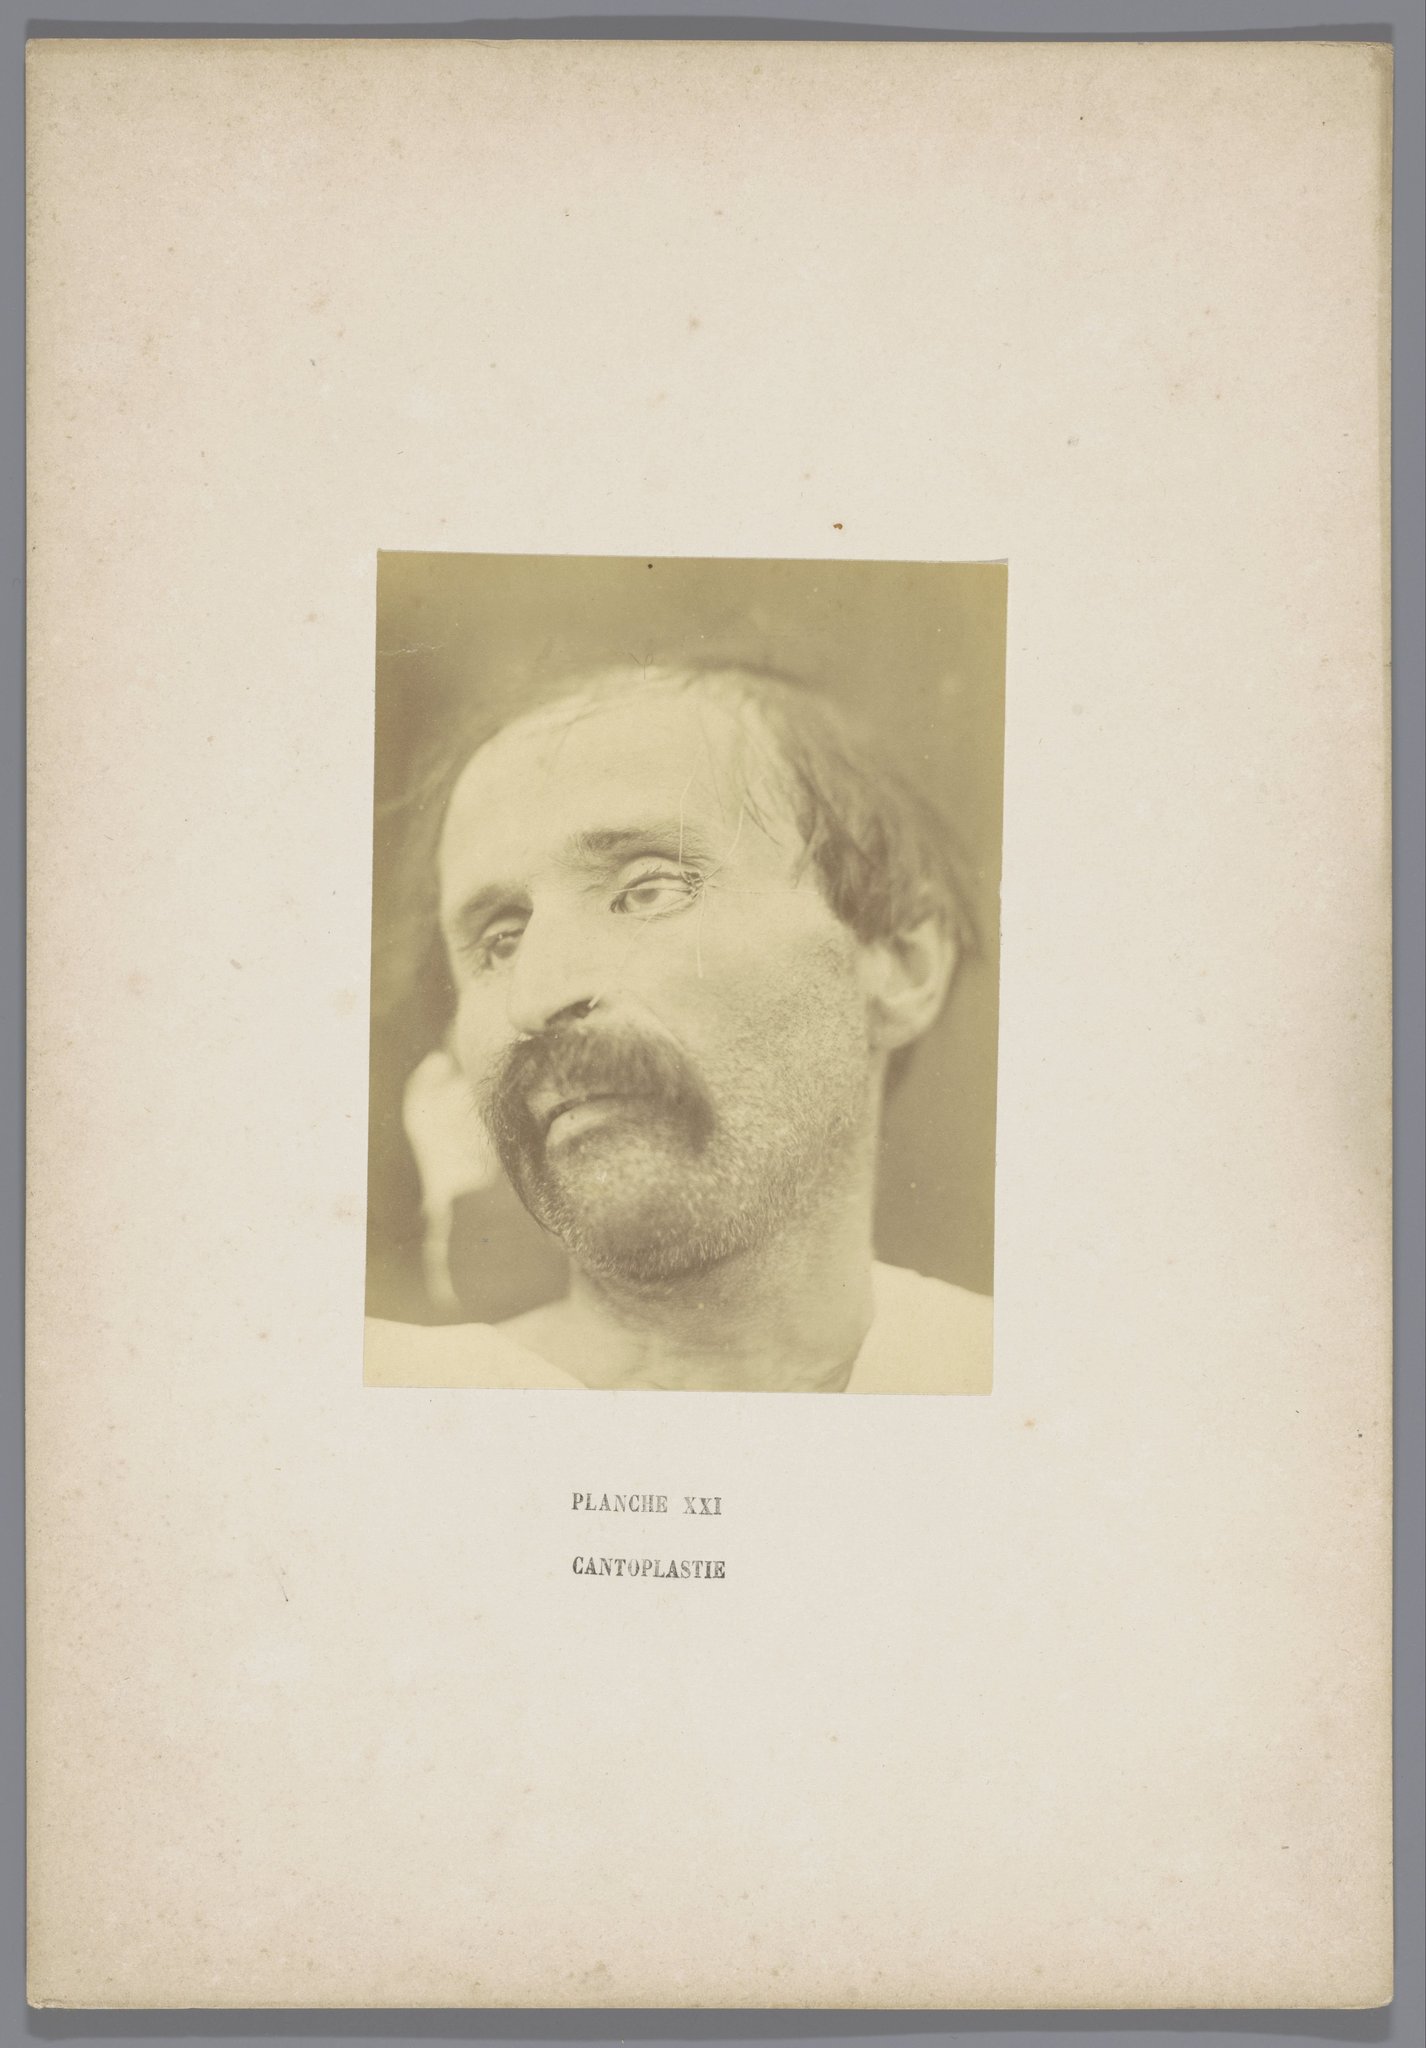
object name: page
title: Cantoplastie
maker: a. de montméja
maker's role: arts, fotograaf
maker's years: 1841-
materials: photographic support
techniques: albumen print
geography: france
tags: eyes, operation, surgery, disabilities affecting the eyes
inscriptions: number: ‘Planche XXI’